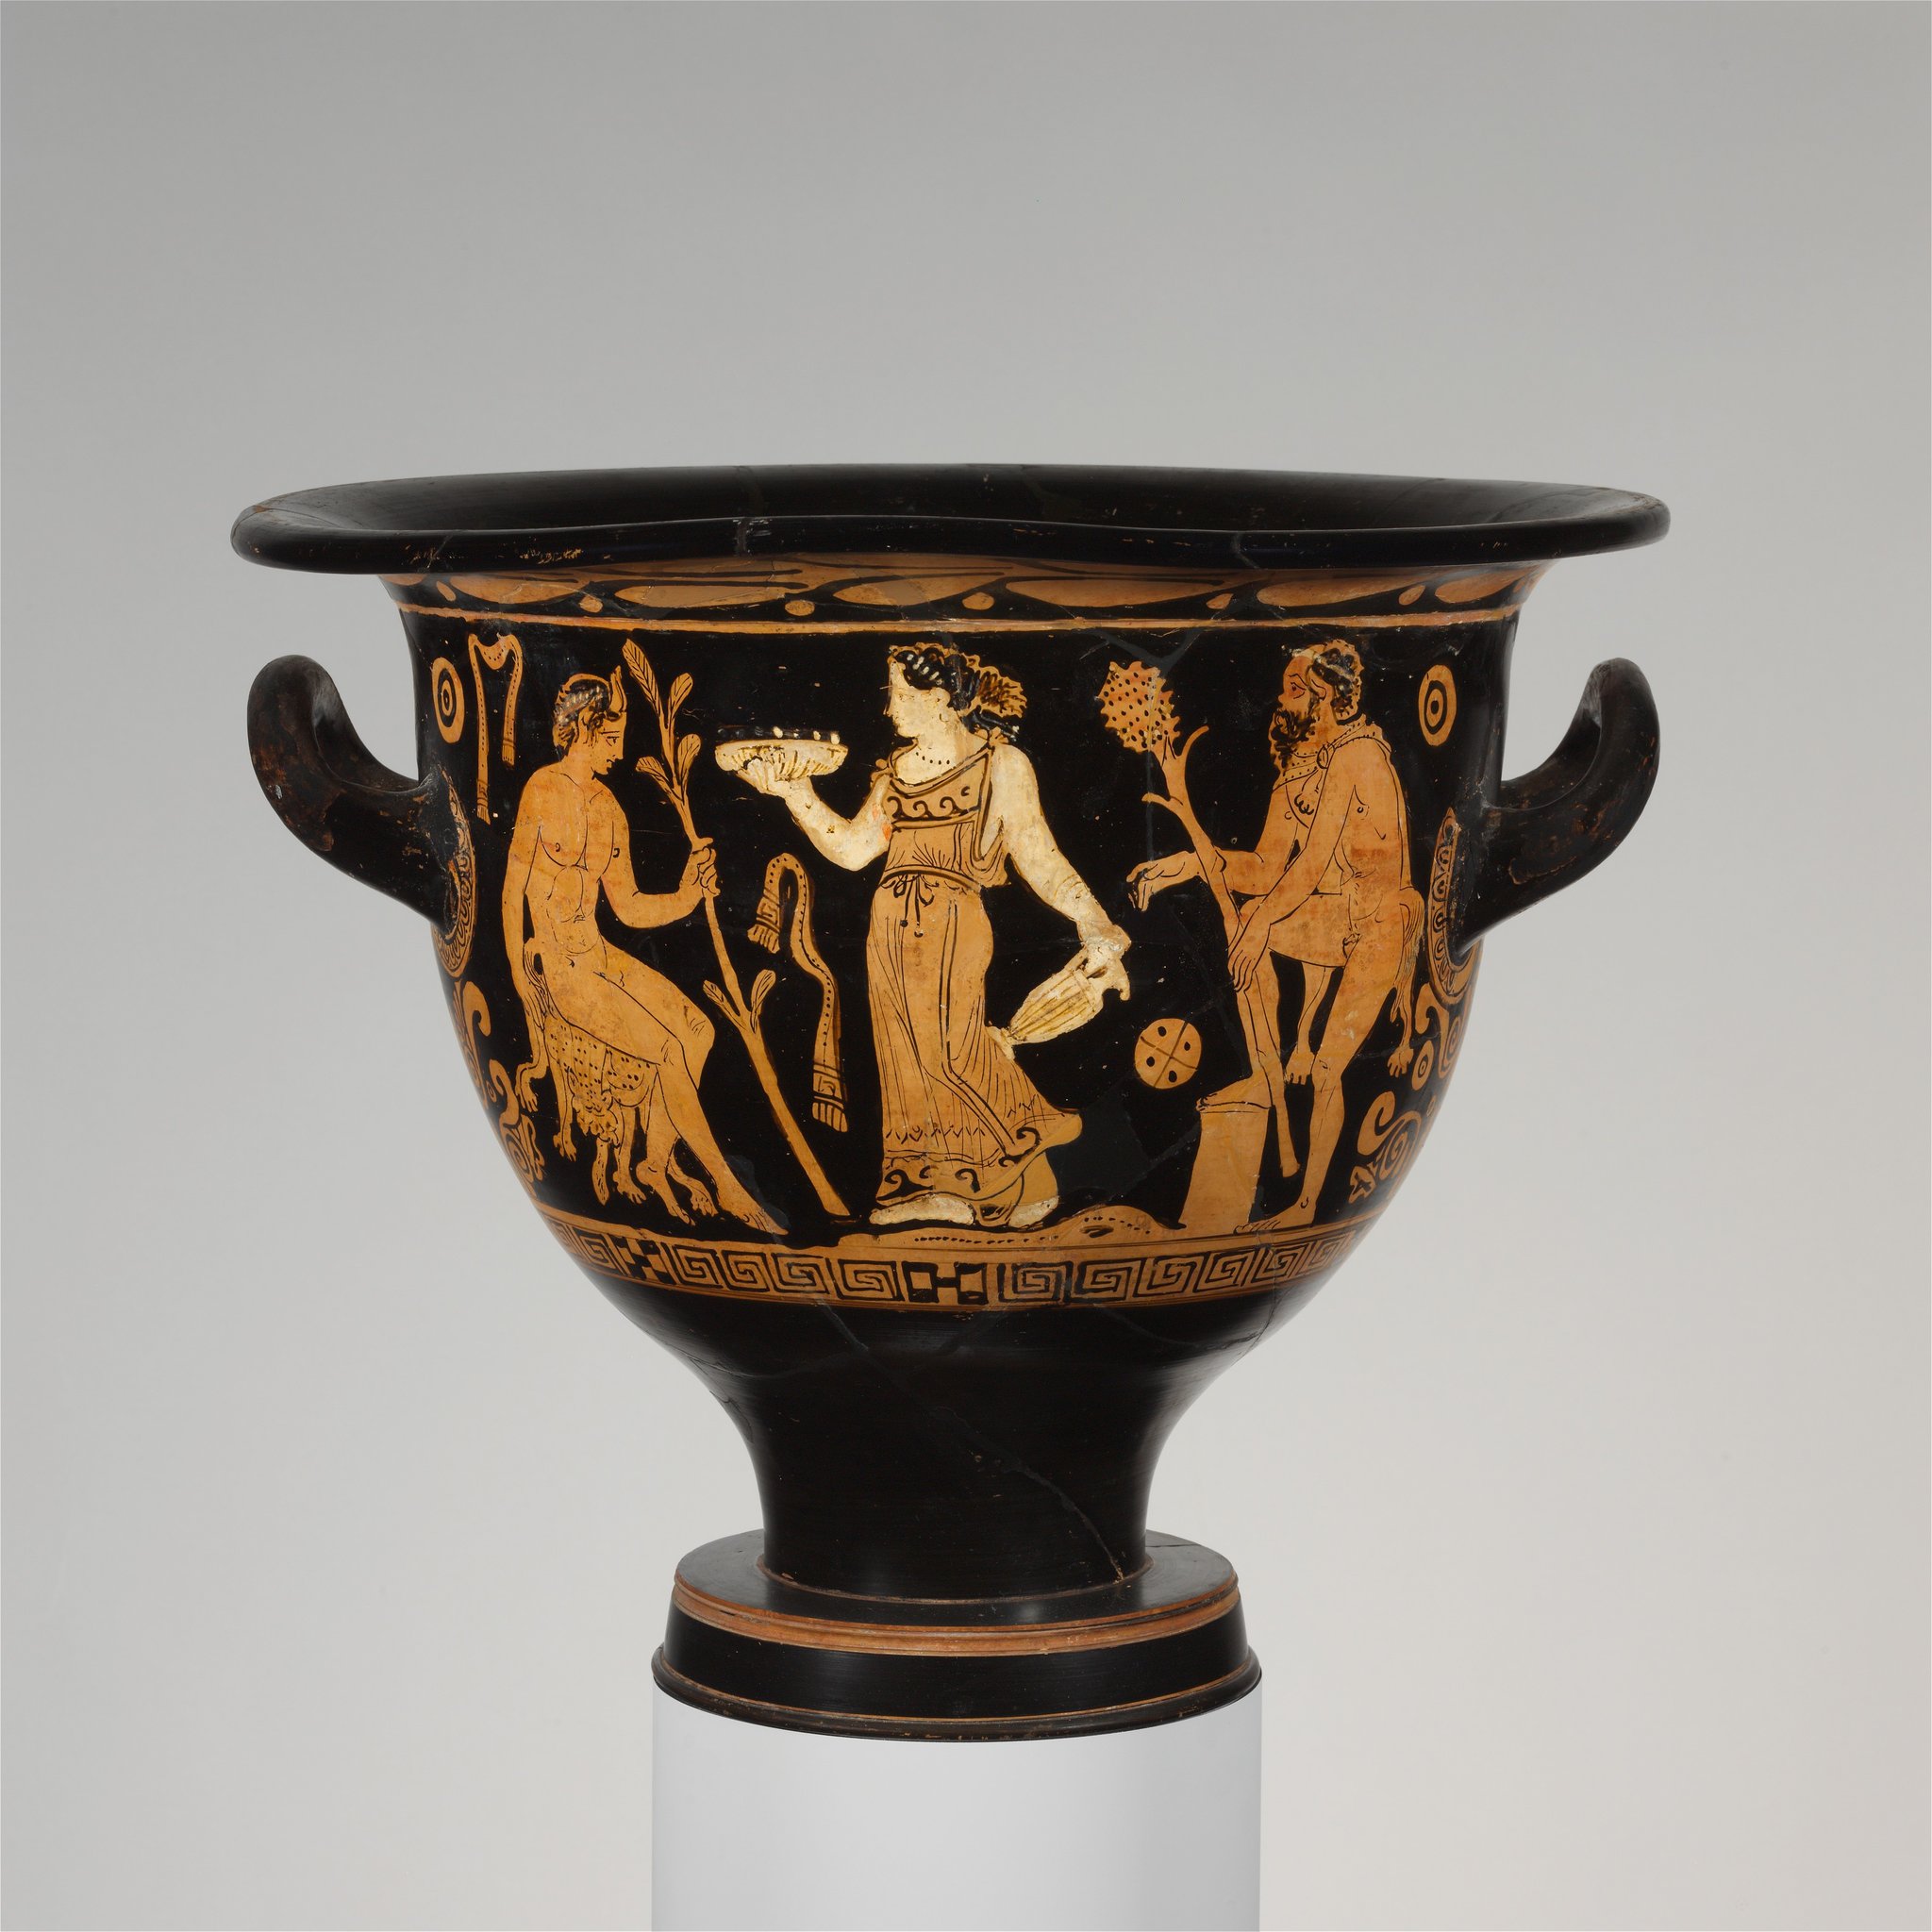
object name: bell krater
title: Terracotta bell-krater (mixing bowl)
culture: etruscan or faliscan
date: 400-368 BCE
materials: terracotta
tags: dionysus,maenads,satyrs